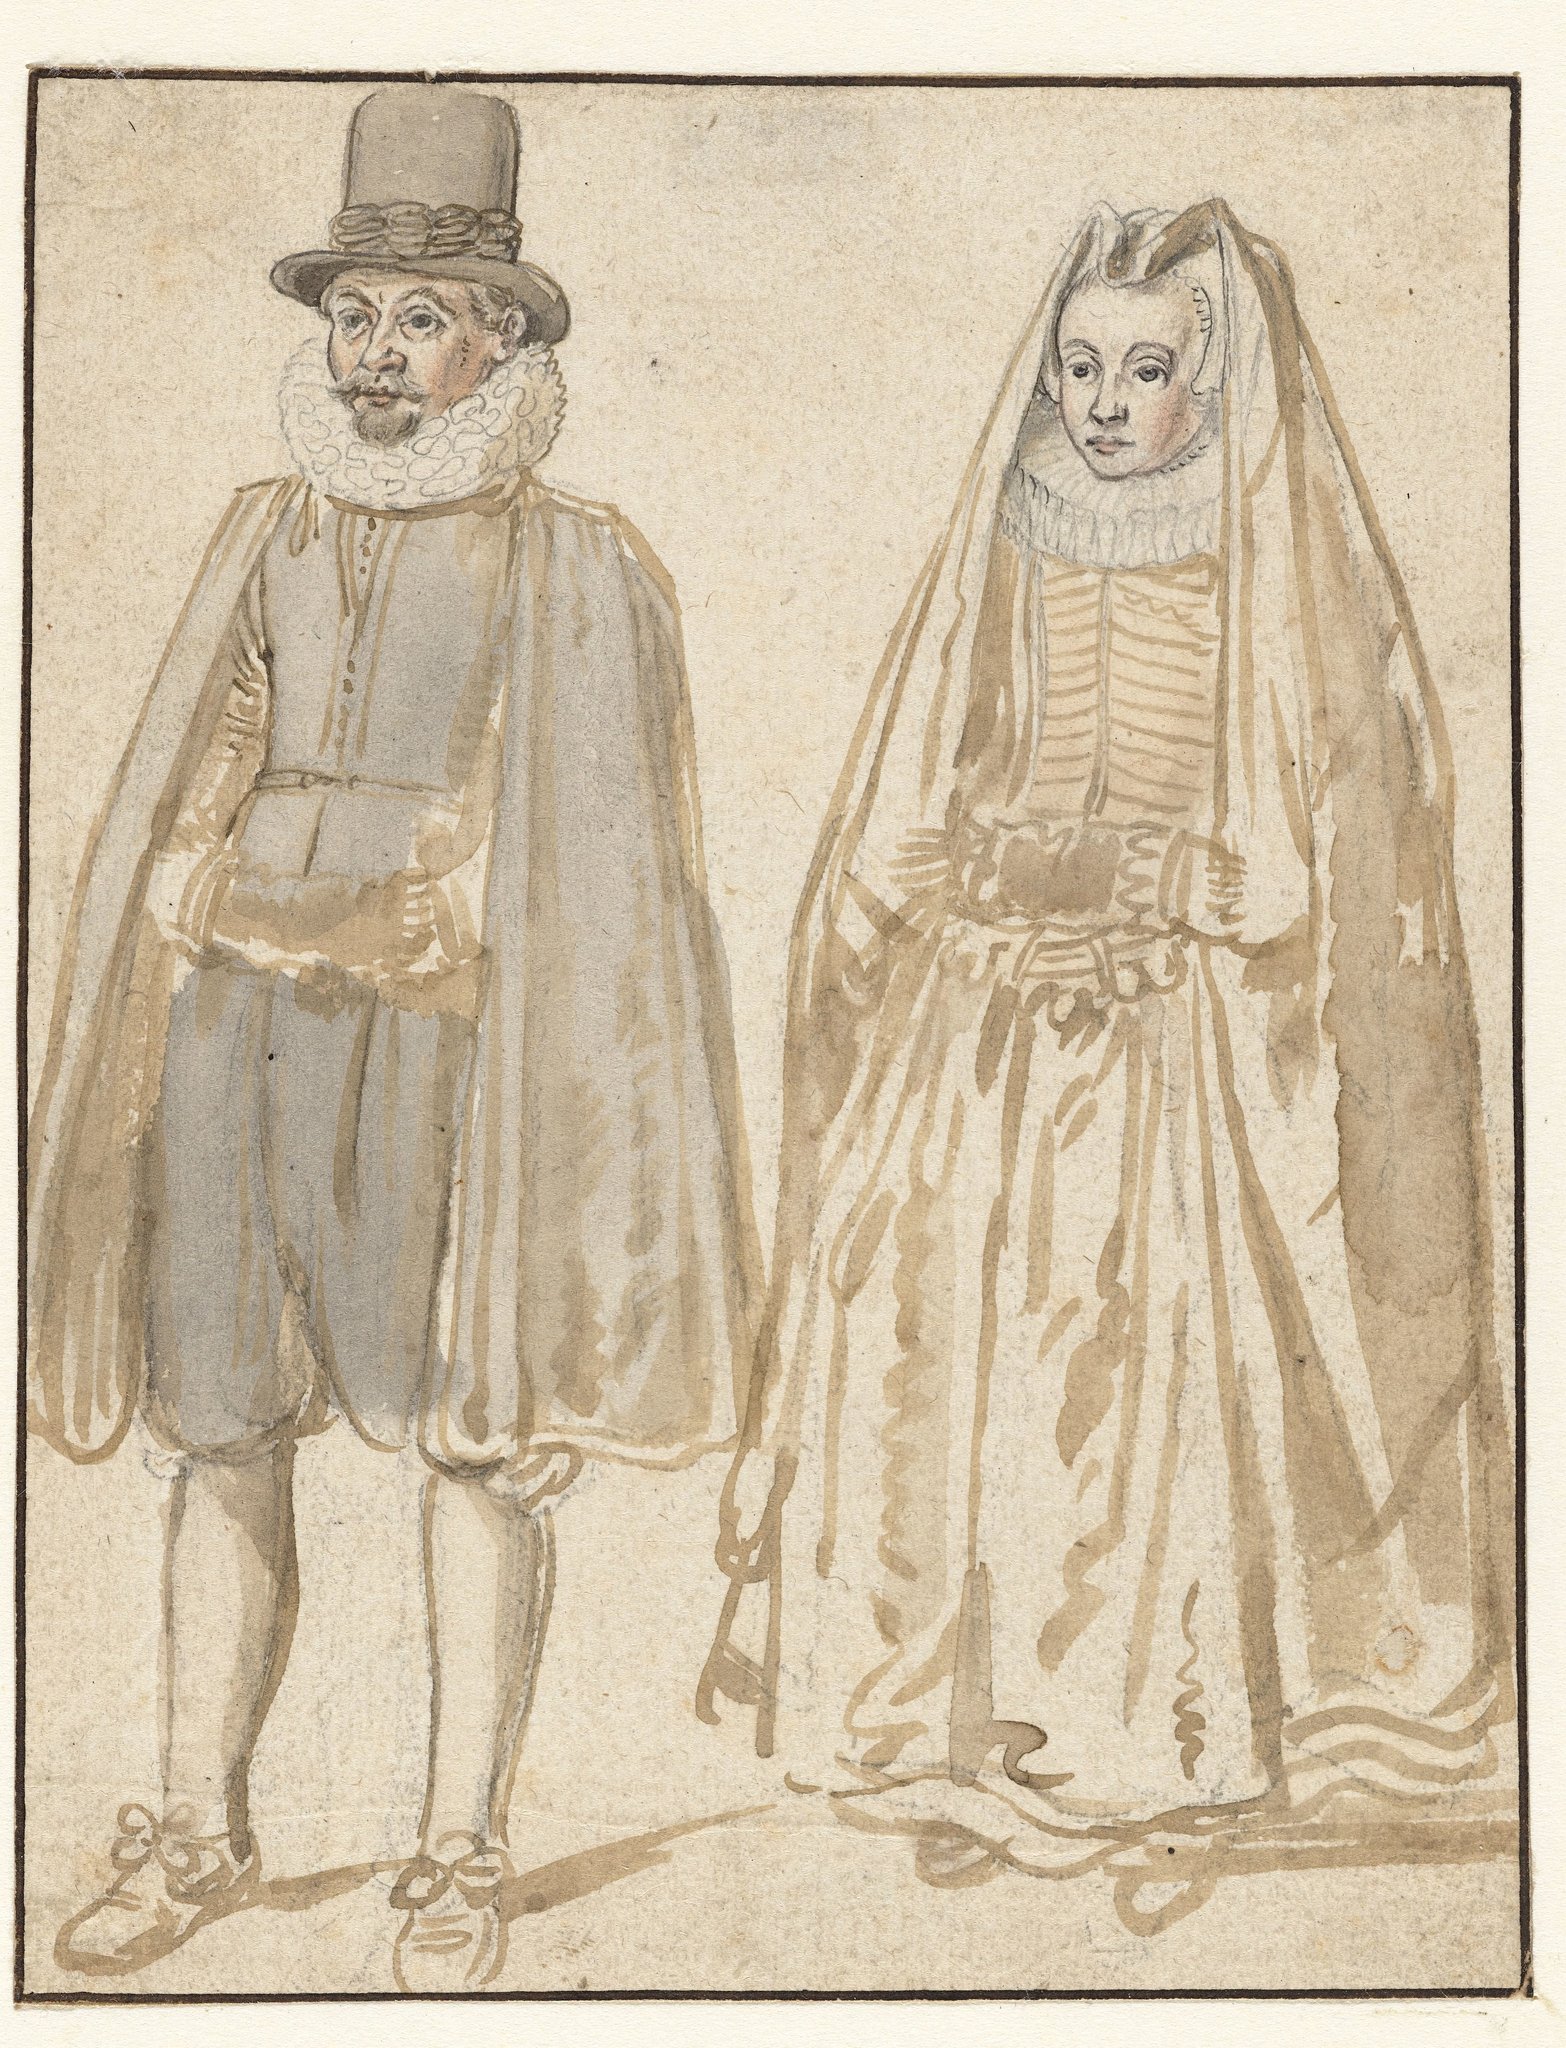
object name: drawing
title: Standing Man and Woman, Seen from the Front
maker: hendrick avercamp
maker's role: draughtsman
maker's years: 1585-1634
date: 1620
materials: ink, paper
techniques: brush, pen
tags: neck-gear ~ clothing (with name) (+ men's clothes), muff (+ men's clothes), cape (+ men's clothes), cape (huik) (+ women's clothes), head-gear: hat (+ men's clothes), neck-gear ~ clothing (with name) (+ women's clothes), skirt (+ women's clothes), dress, gown (+ women's clothes), shoes, sandals (+ men's clothes), trousers, breeches, etc. (breeches) (+ men's clothes), clothing for the upper part of the body (doublet) (+ men's clothes), clothing for the upper part of the body (with name) (+ women's clothes), muff (+ women's clothes)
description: Staande man en vrouw, van voren, gekleed volgens de burgerlijke mode van ca. 1615; beiden hebben de handen in een mof.